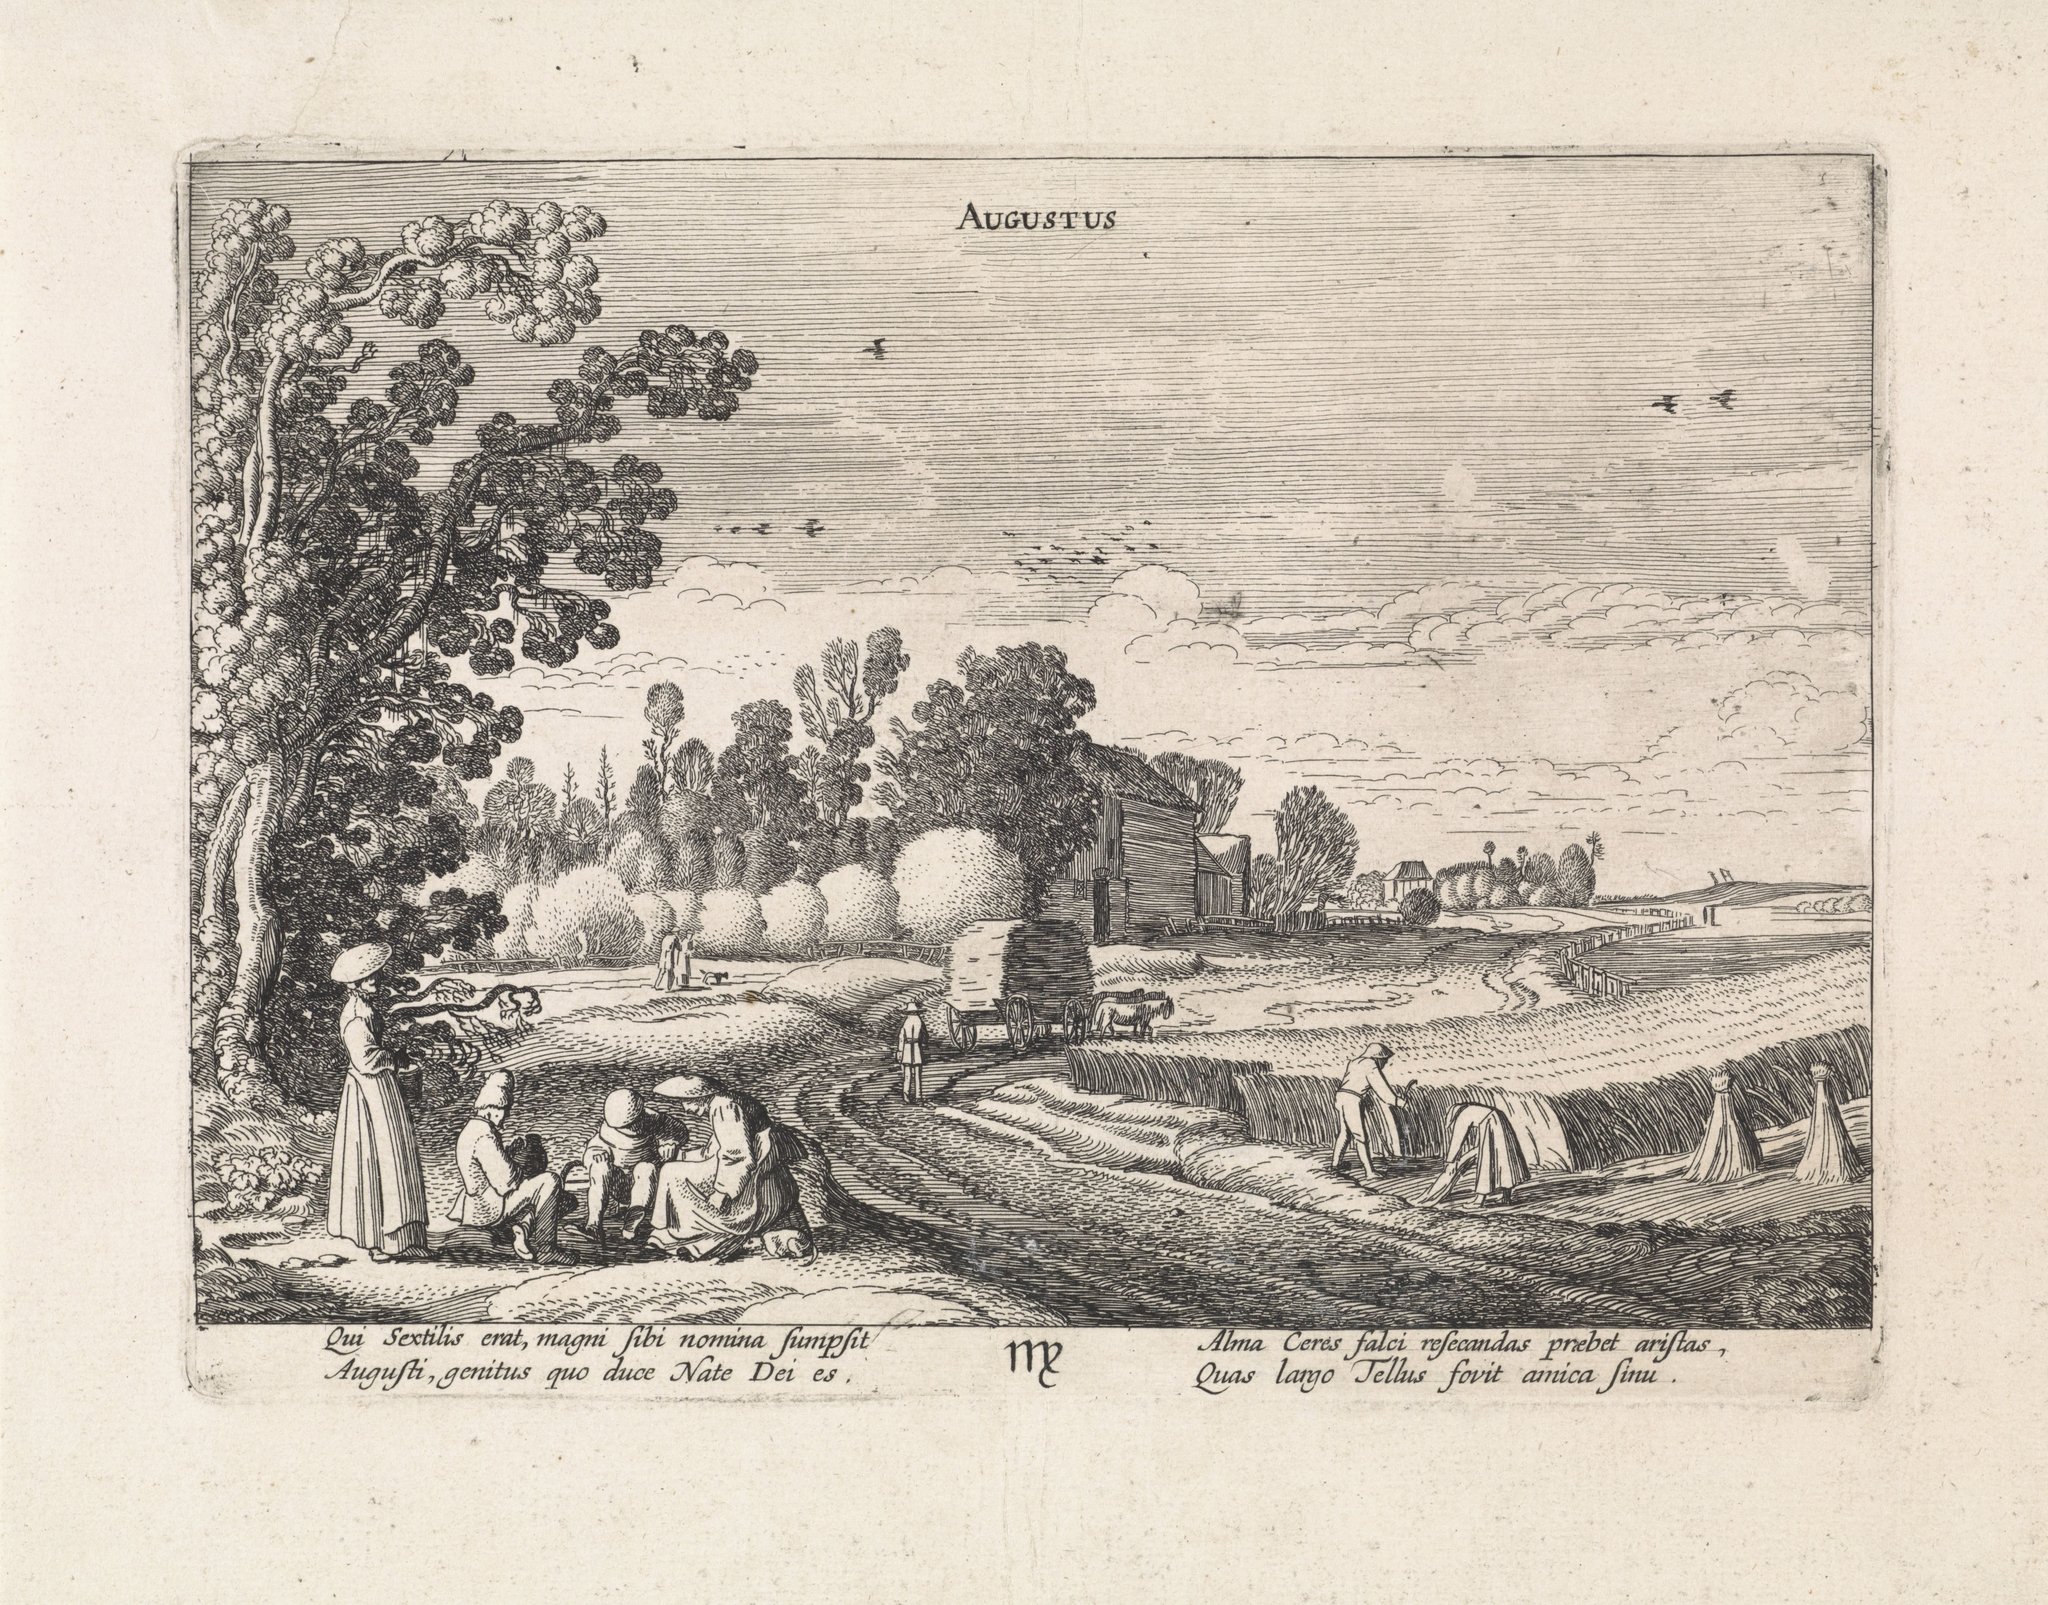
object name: print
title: Duodecim anni mensium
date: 1608-1618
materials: paper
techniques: etching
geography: northern netherlands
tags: virgo (zodiacal sign of august), landscape symbolizing august, transporting ~ harvest, cereal, grain, corn (grass with grains, grown for food, e.g.: wheat, rice, rye, oats, maize, buckwheat, millet), binding ~ harvest, rest during harvest (eating, dancing, making love, etc.)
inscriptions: collector's mark: Lugt 964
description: Een landschap met oogstende boeren en korenschoven op het land, voorstellende de maand augustus. Linksvoor een groep rustende figuren. Onderaan het astrologische symbool van het sterrenbeeld maagd. Prent uit een serie van twaalf.